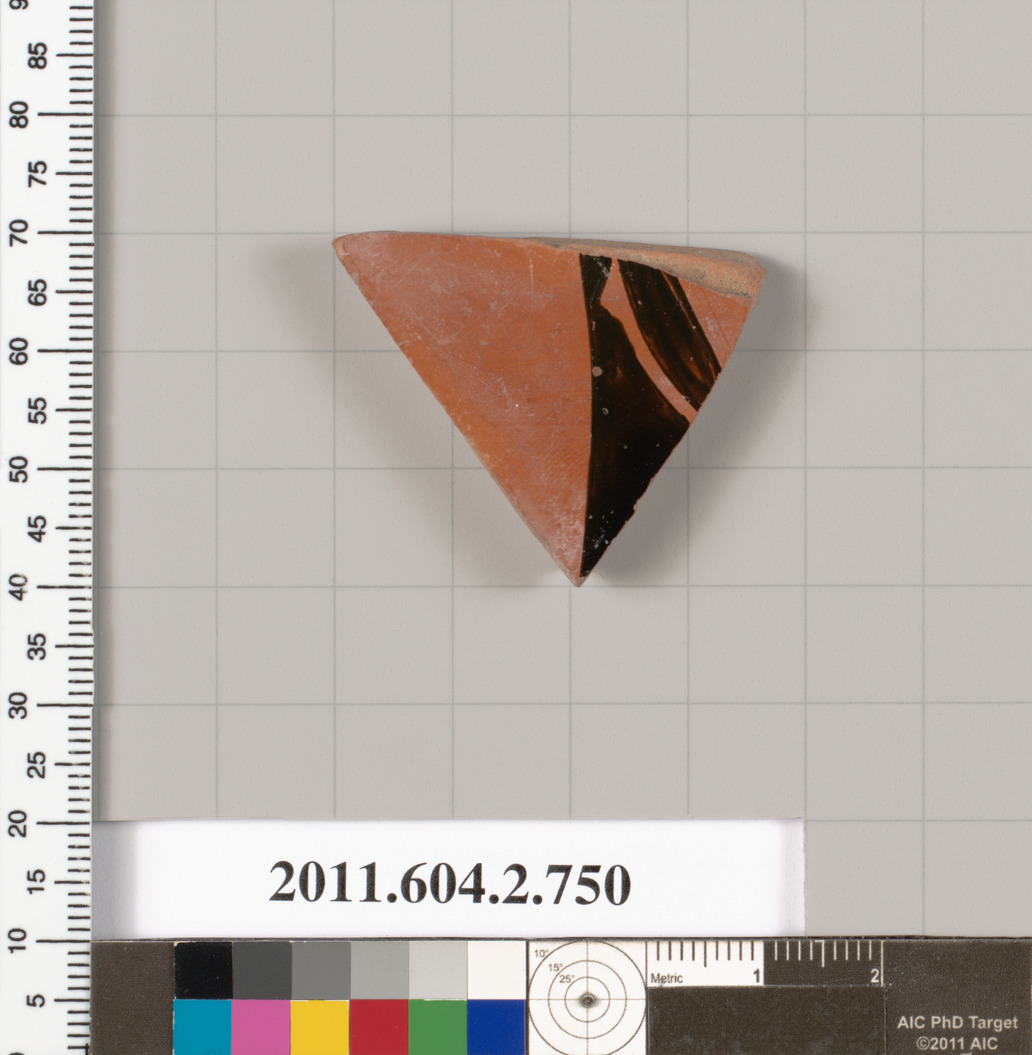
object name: calyx krater fragment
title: Terracotta fragment of a calyx-krater (bowl for mixing wine and water)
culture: greek, attic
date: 475-451 BCE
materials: terracotta